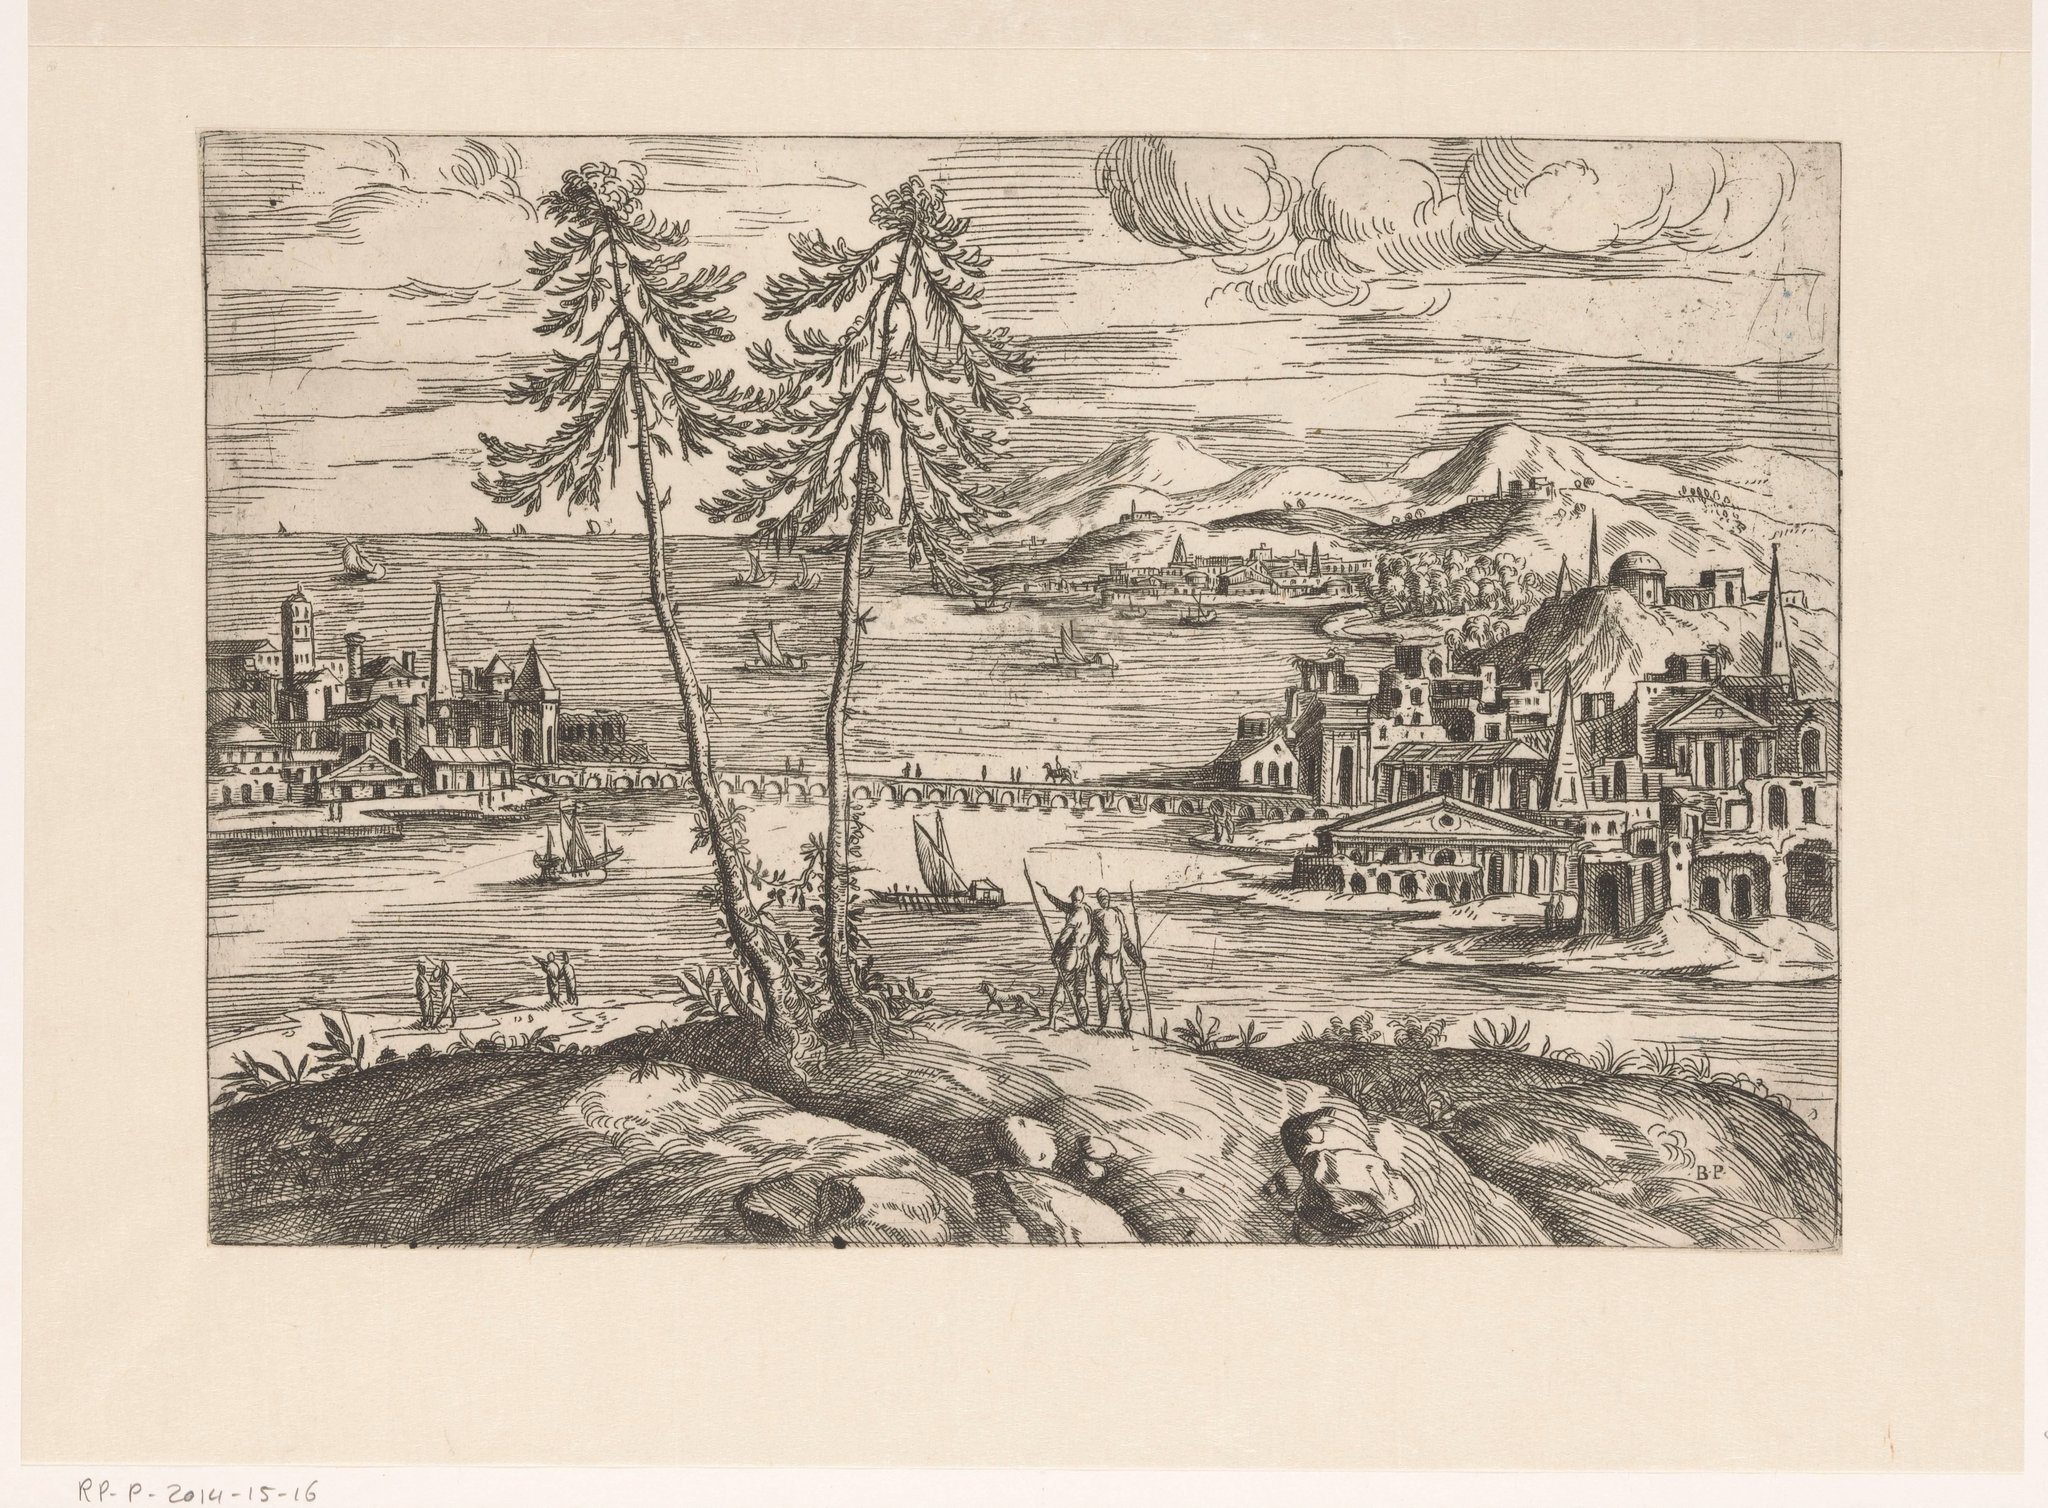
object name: print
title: Landschappen met ruïnes en fantasie-architectuur en figuren in antieke en exotische dracht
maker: giovanni battista pittoni (i)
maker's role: print maker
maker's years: 1520-1583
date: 1560-1570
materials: paper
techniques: etching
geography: vicenza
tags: landscape with ruins, fantastic architecture, unrealistic architectural fantasies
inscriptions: collector's mark: Lugt 2228, collector's mark: Lugt 2760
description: Vermoedelijk is deze prentreeks onbeschreven (vergelijk Passavant, deel 6 p. 169-170, nr. 1). Het is vooralsnog onduidelijk of de reeks compleet is of wellicht uit meer prenten bestond.